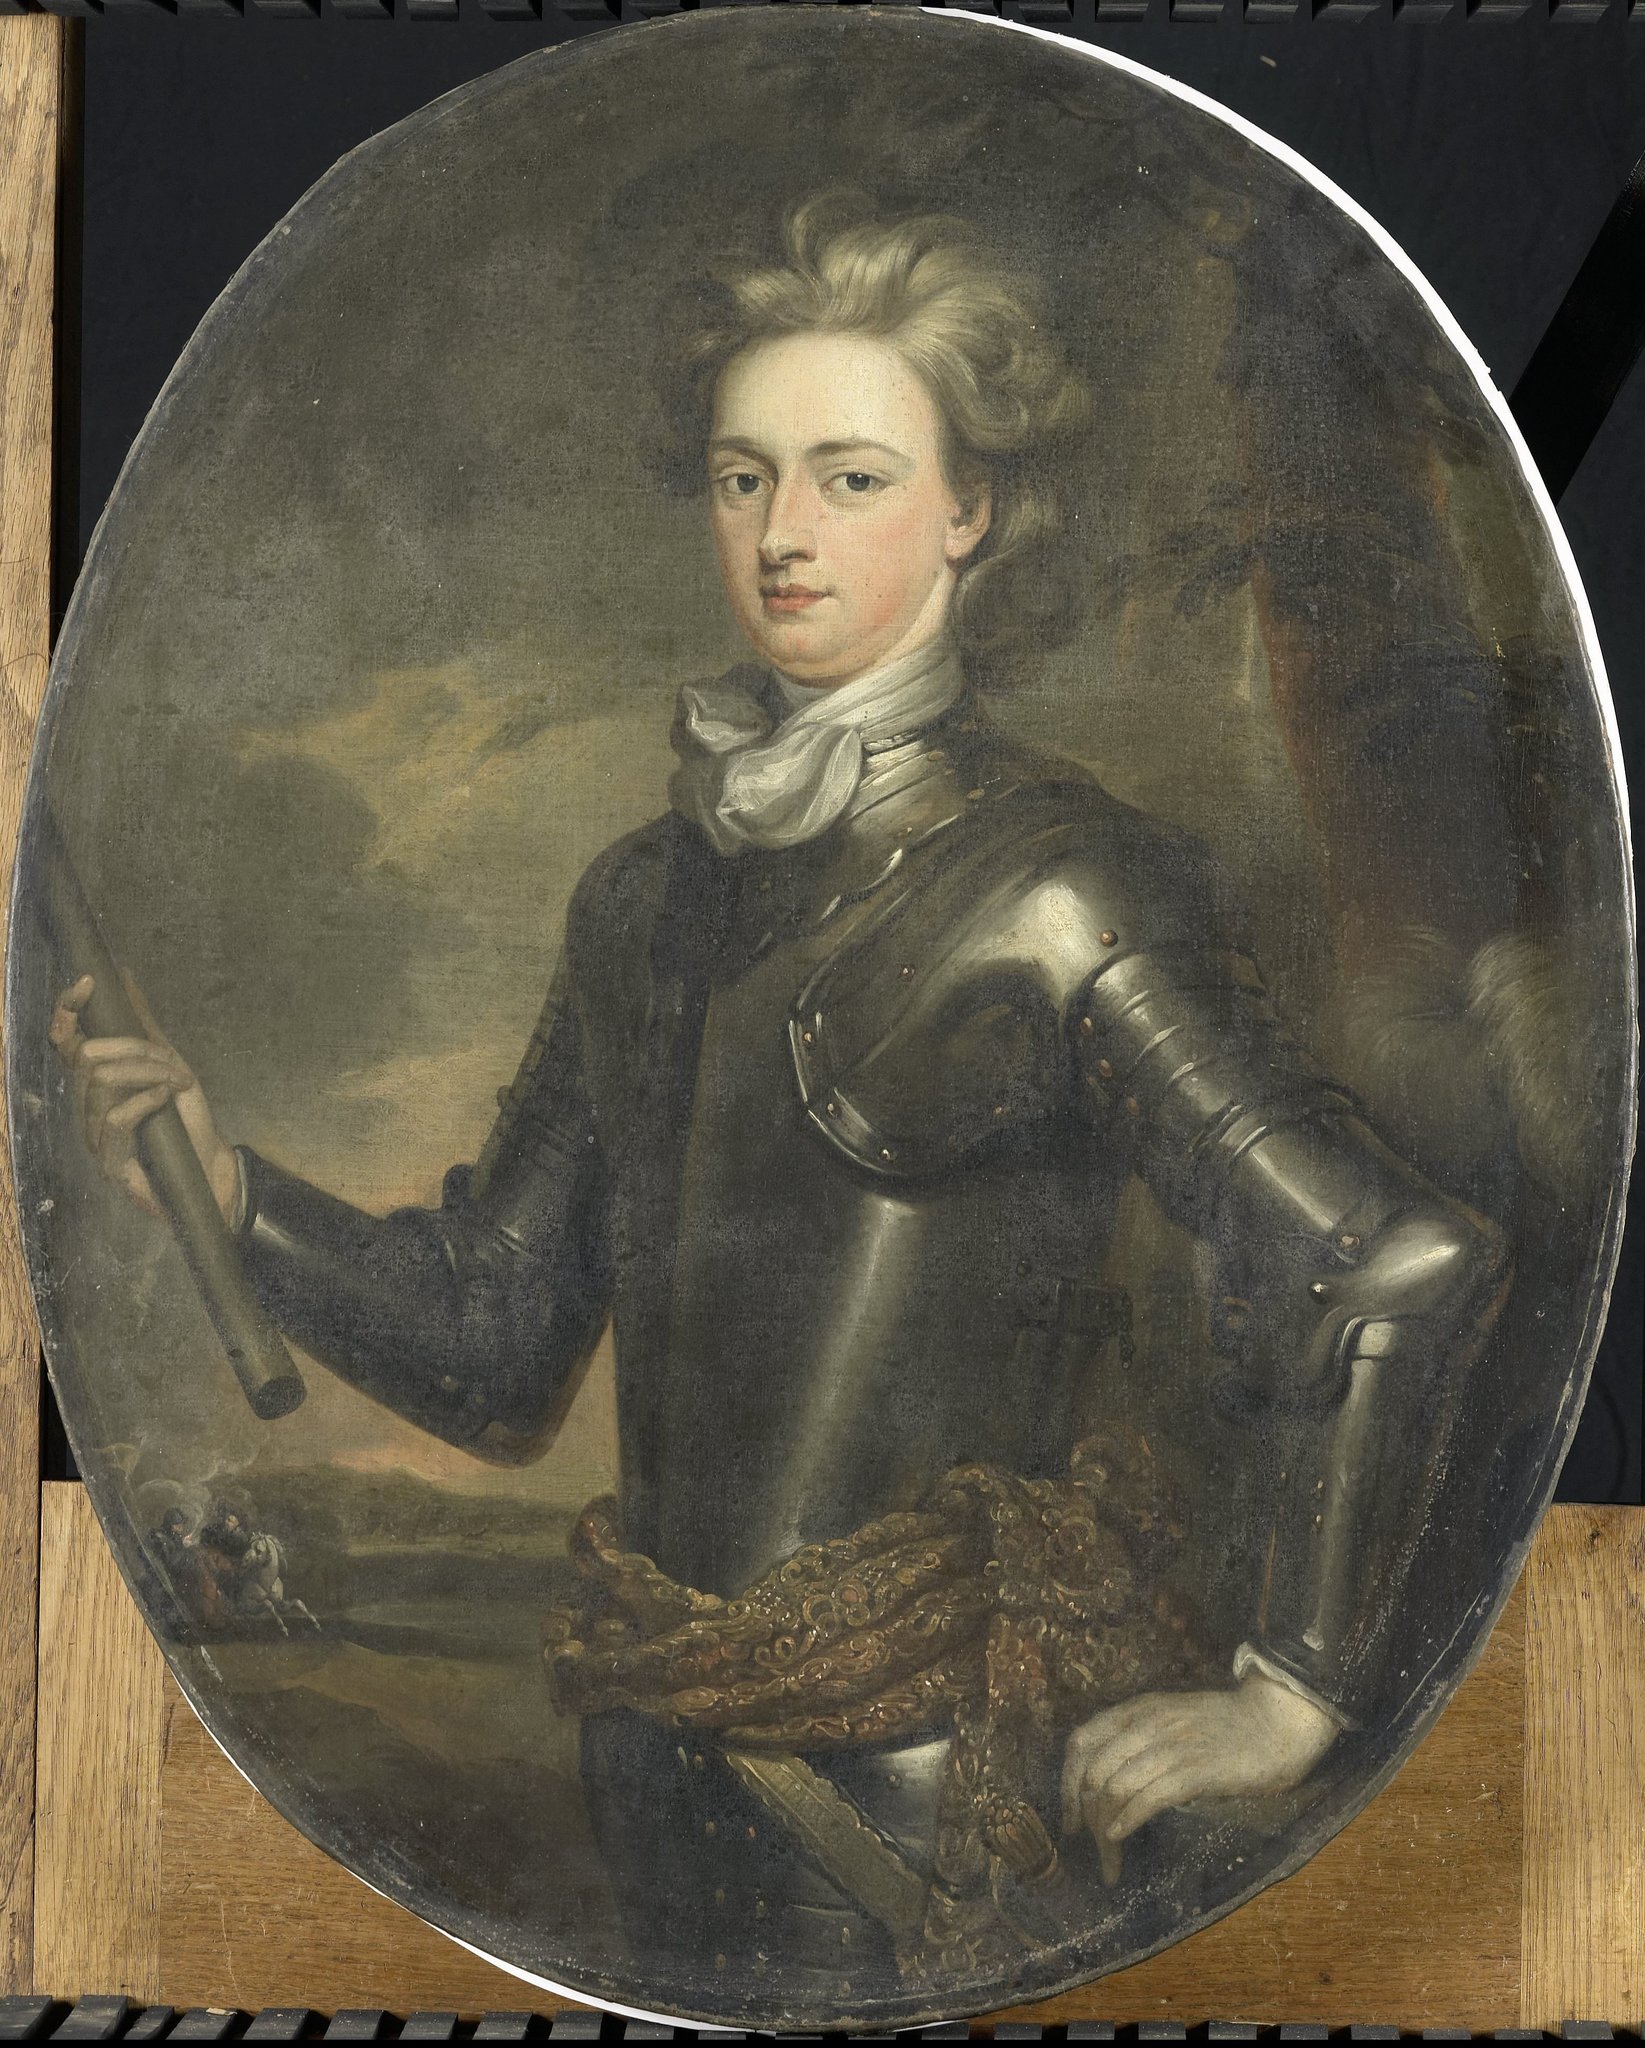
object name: painting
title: Portrait of the first Earl of Albemarle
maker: hendrik carré (i)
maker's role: painter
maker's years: 1656-1721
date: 1697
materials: canvas, oil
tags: the hague, historical persons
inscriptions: signature and date: ‘H. Carré 1697’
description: Portret van Arnold Joost van Keppel, de eerste graaf van Albemarle. Ten halven lijve, staand, in wapenrusting, commandostaf in de rechterhand, de linkerhand in de zij. Links op de achtergrond twee vechtende ruiters. Kopie door Hendrik Carré (I) naar het origineel van Sir Gottfried Kneller.